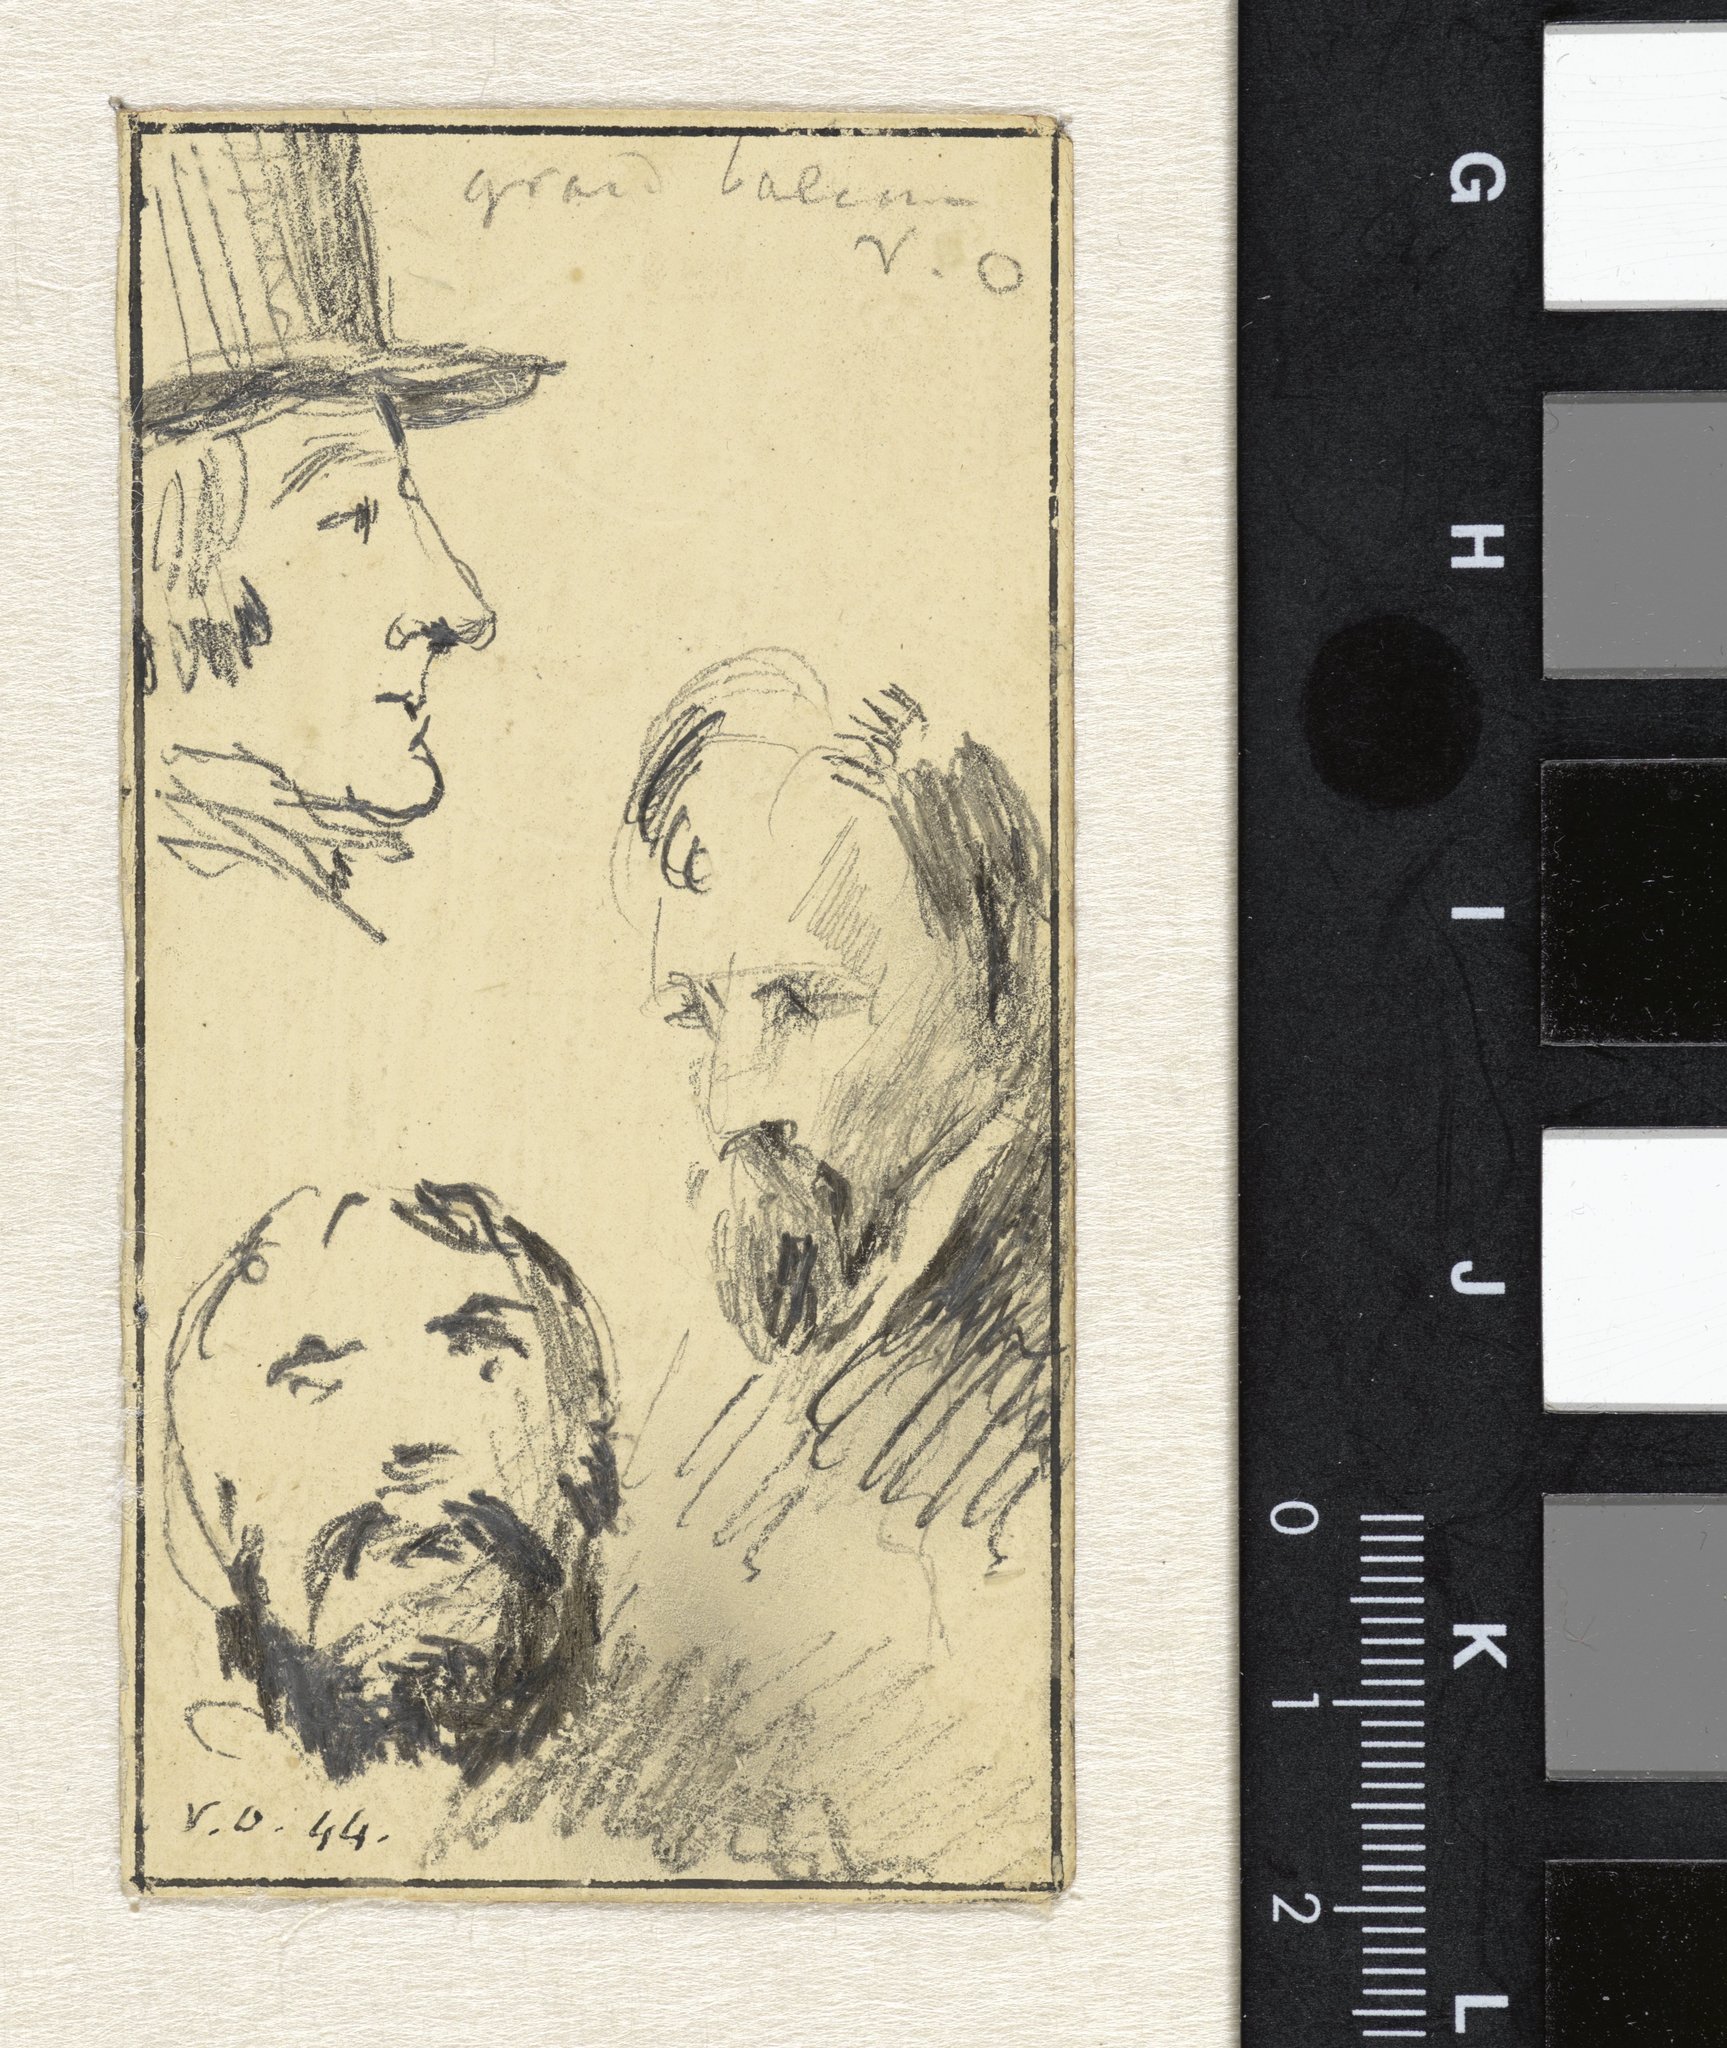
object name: drawing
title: Studies van drie mannenhoofden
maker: georgius jacobus johannes van os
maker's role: draughtsman, painter, print maker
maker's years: 1782-1861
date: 1844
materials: paper, pencil